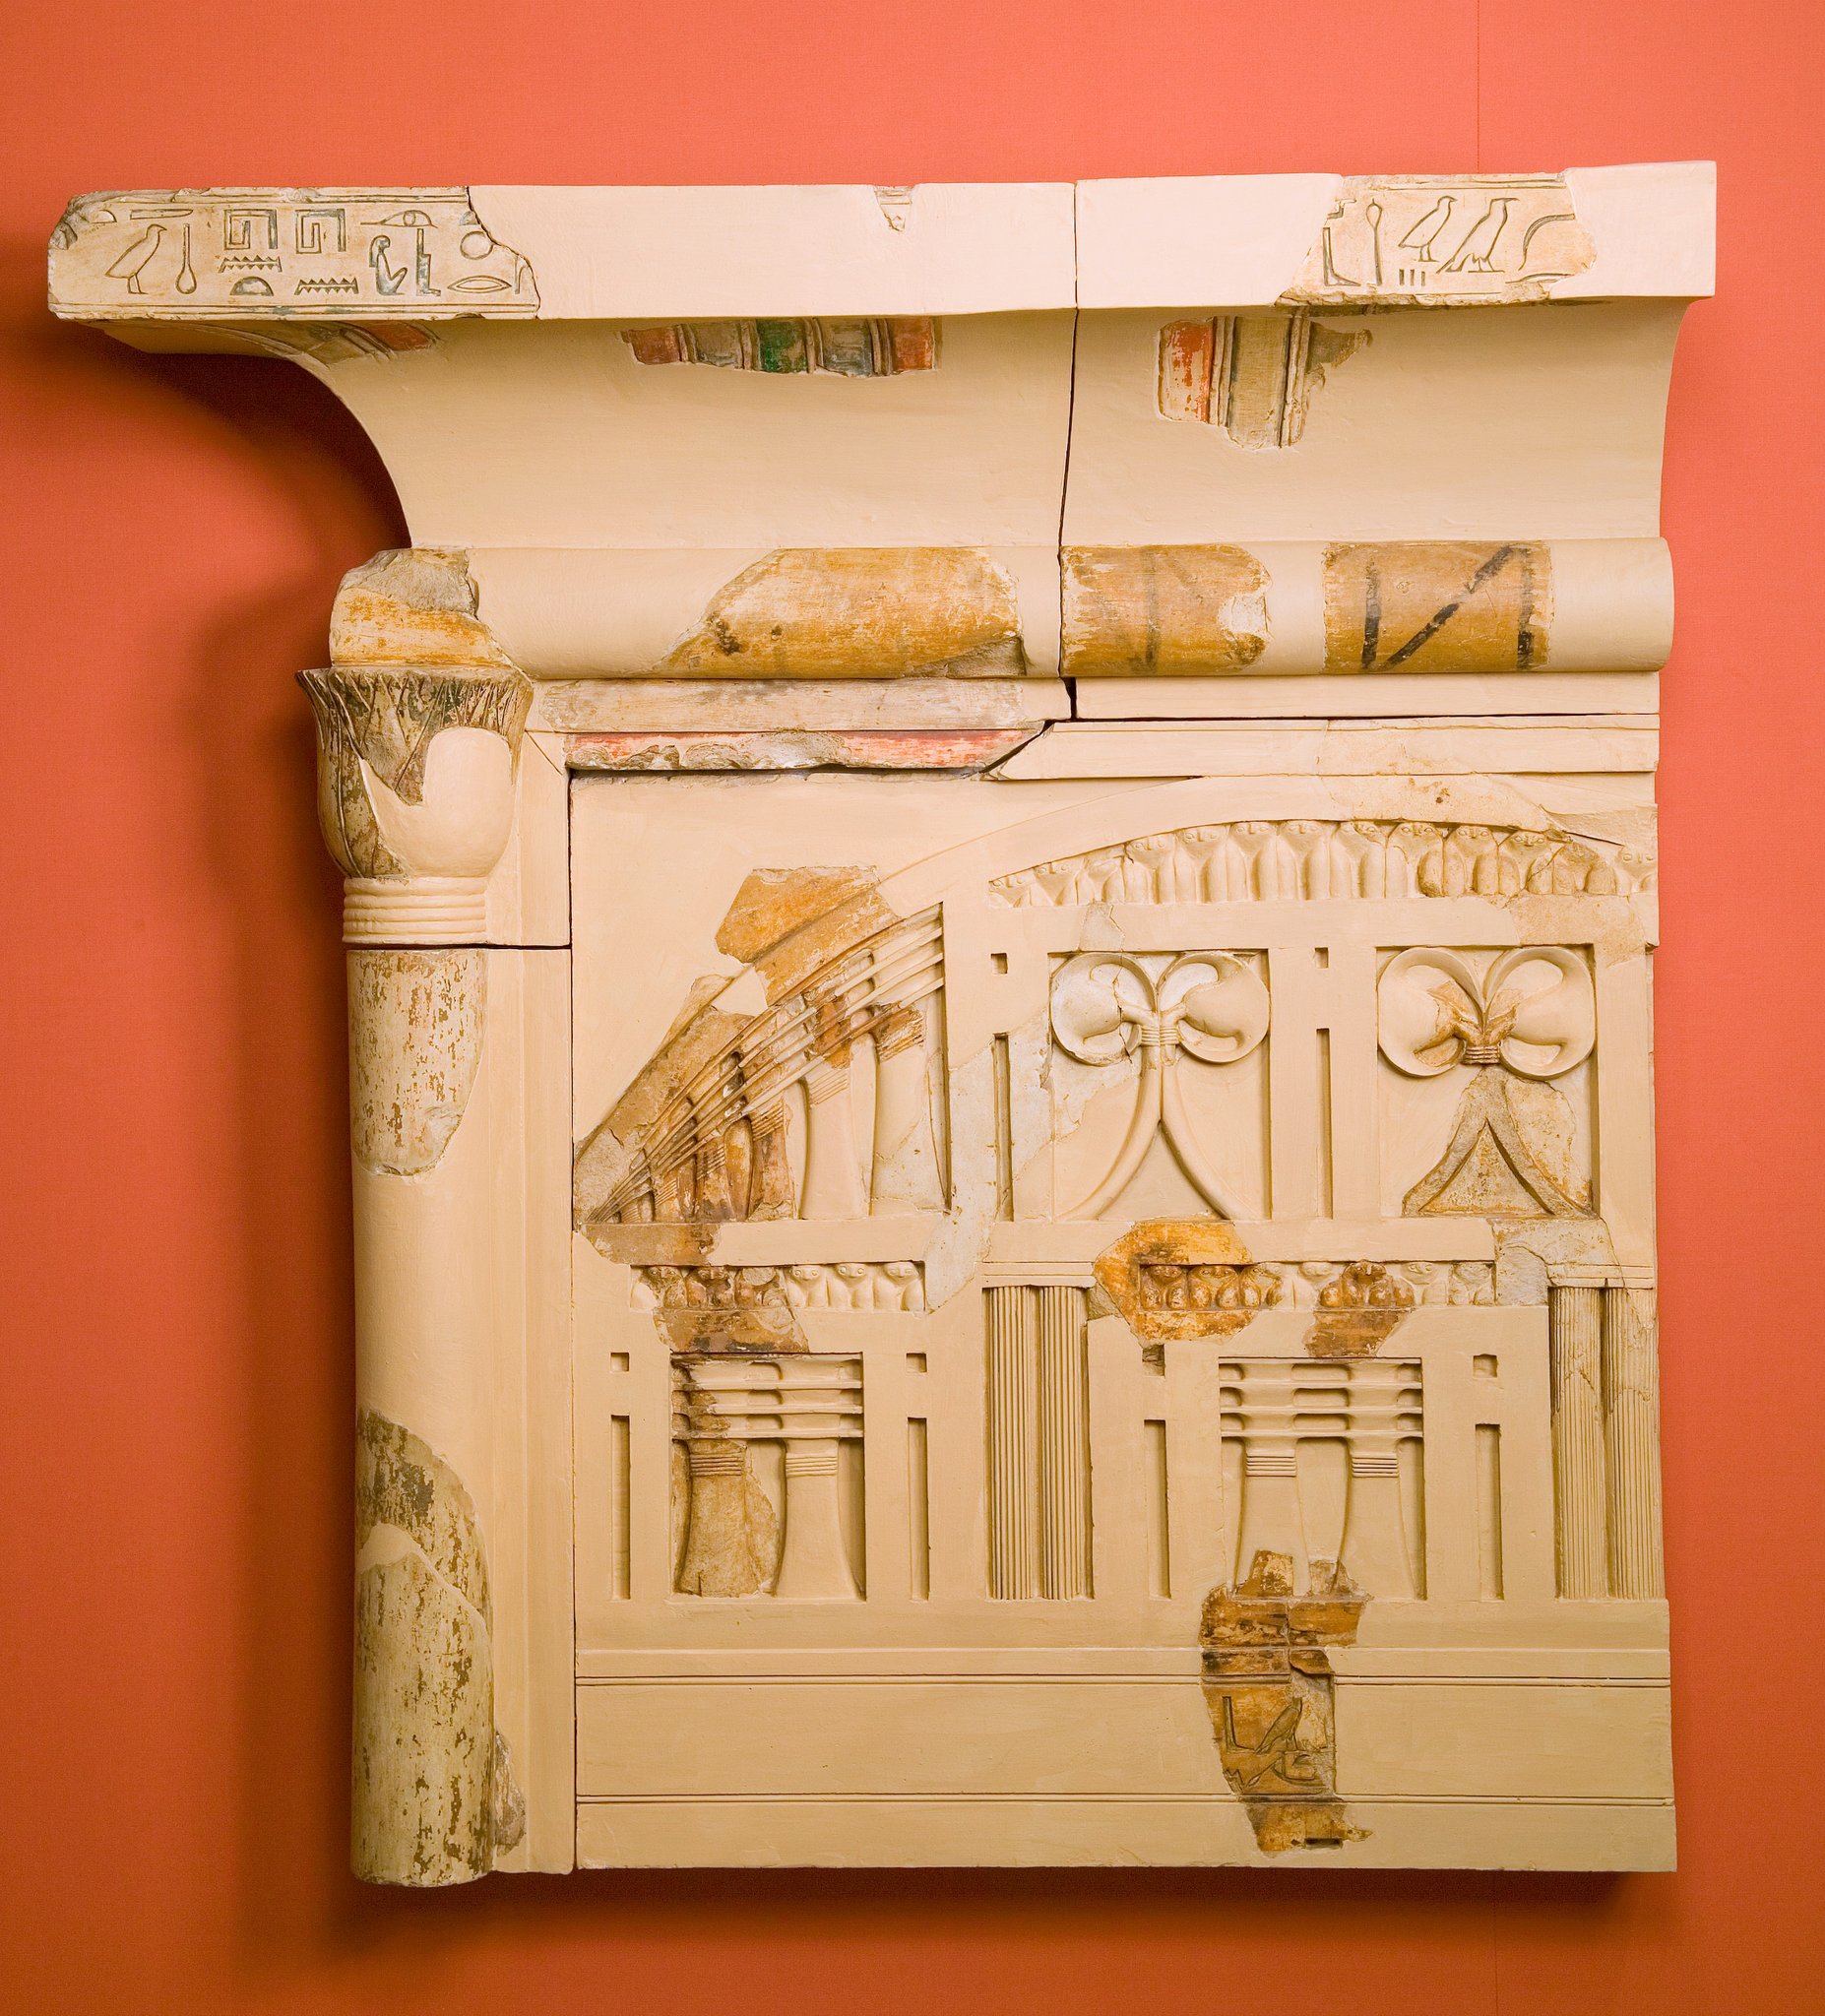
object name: relief block, shrine, henhenet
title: Part of the shrine of Queen Henhenet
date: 2051-2030 BCE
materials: limestone, paint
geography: egypt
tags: hieroglyphs